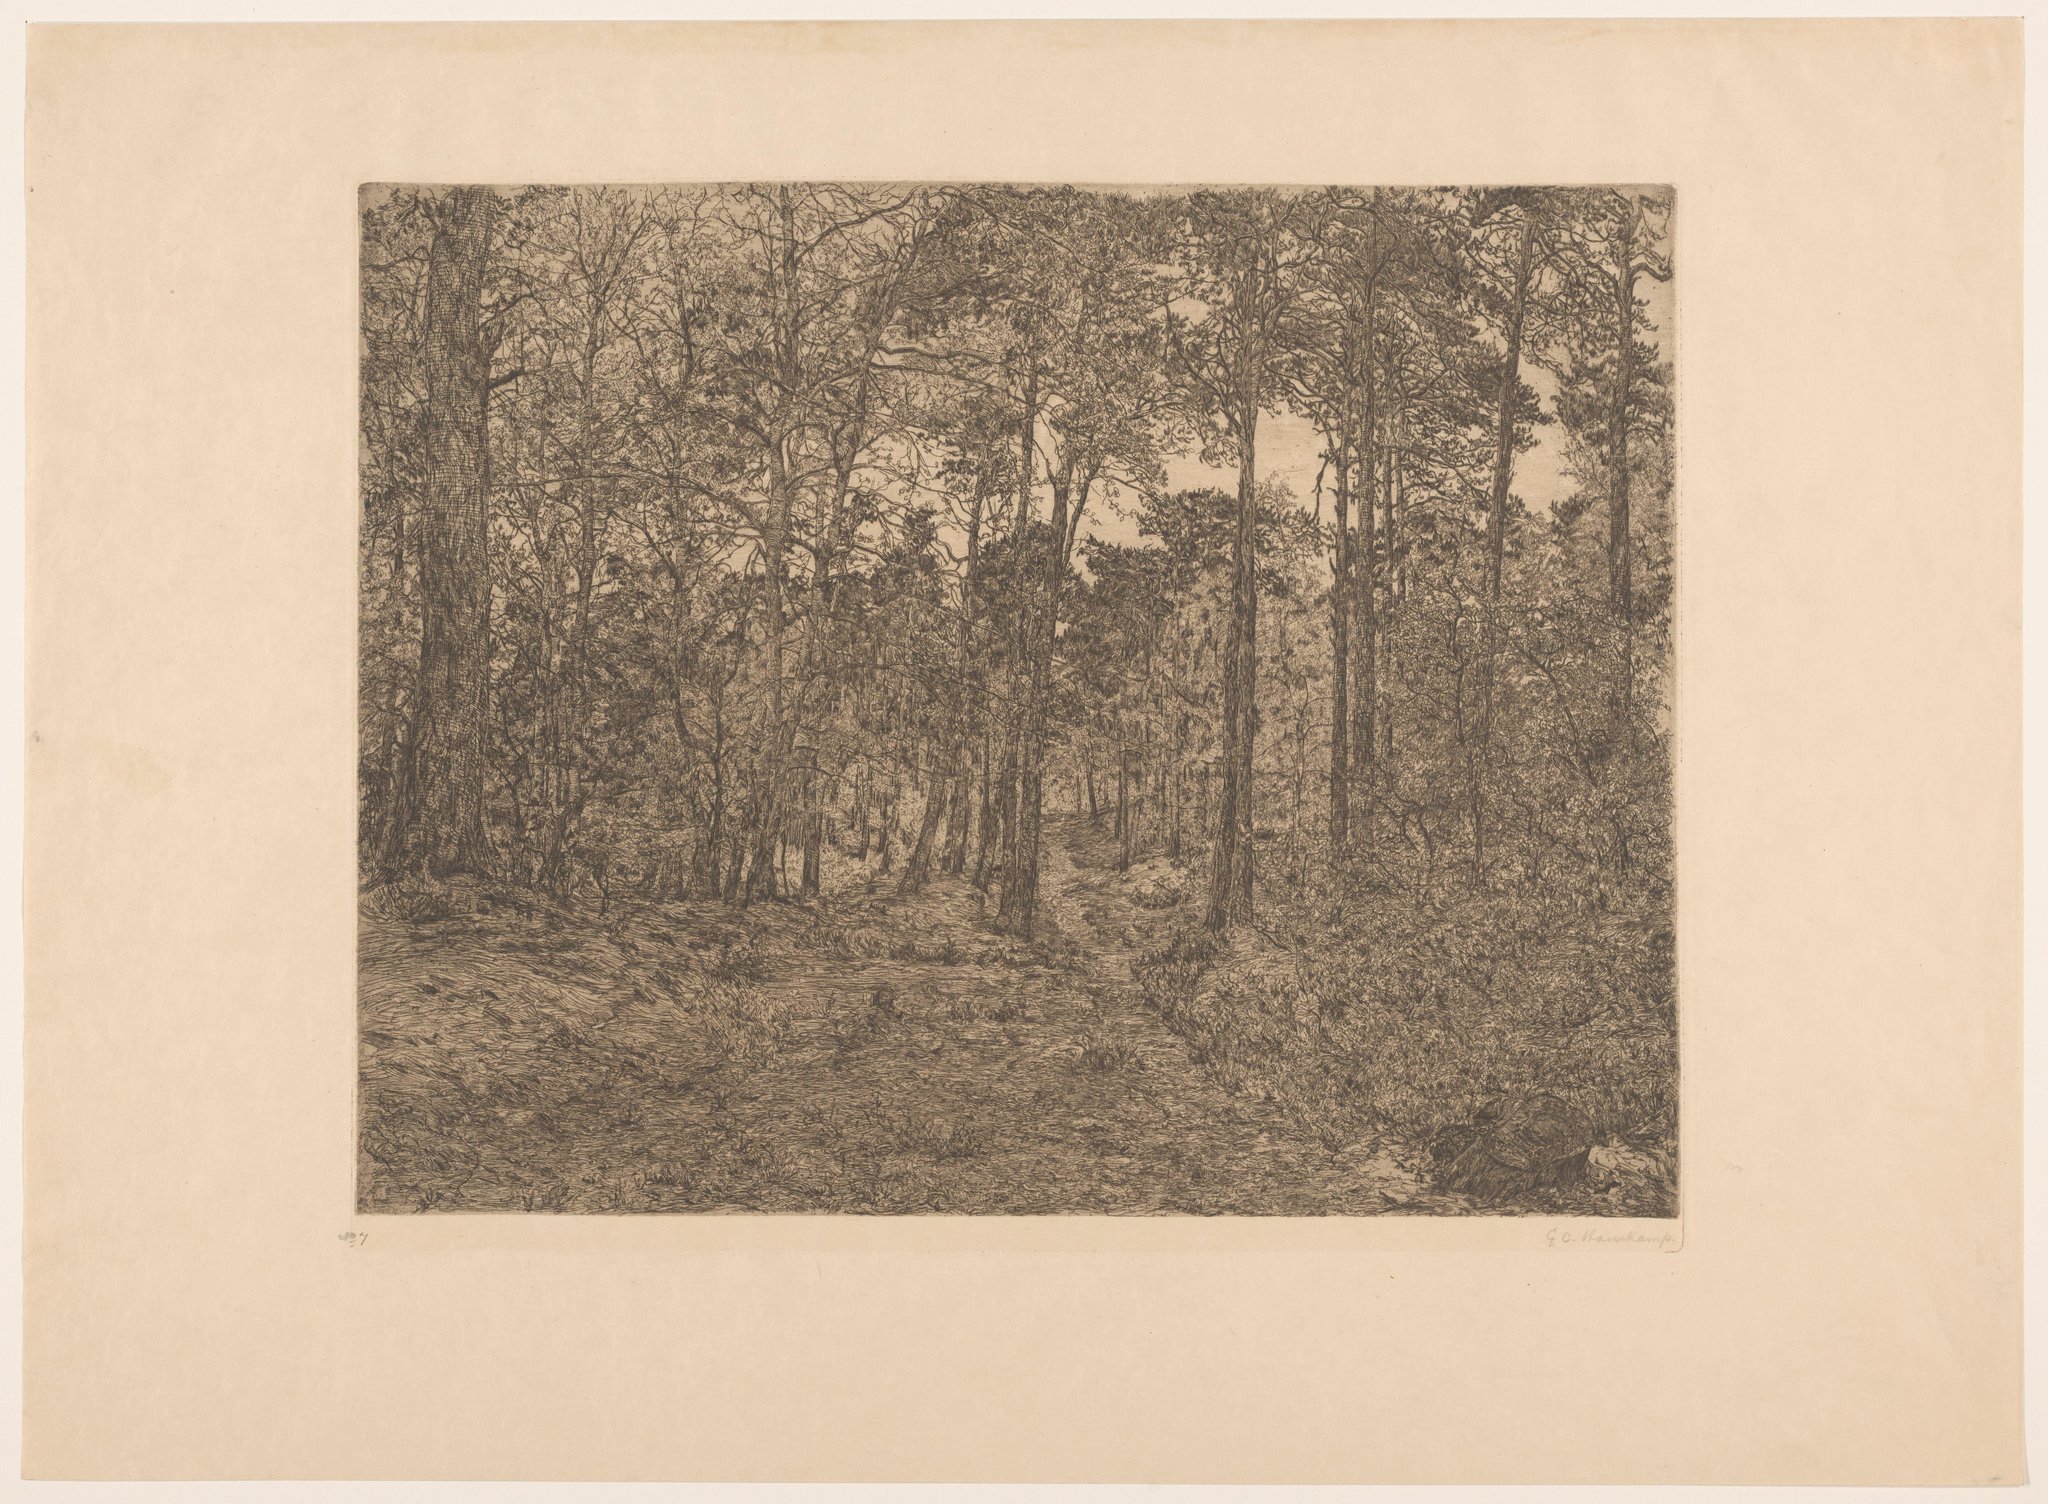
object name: print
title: Bosgezicht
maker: gerrit haverkamp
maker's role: print maker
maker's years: 1872-1926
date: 1882-1926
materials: paper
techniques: etching, intaglio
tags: forest, wood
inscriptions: inscription: ‘No. 7’